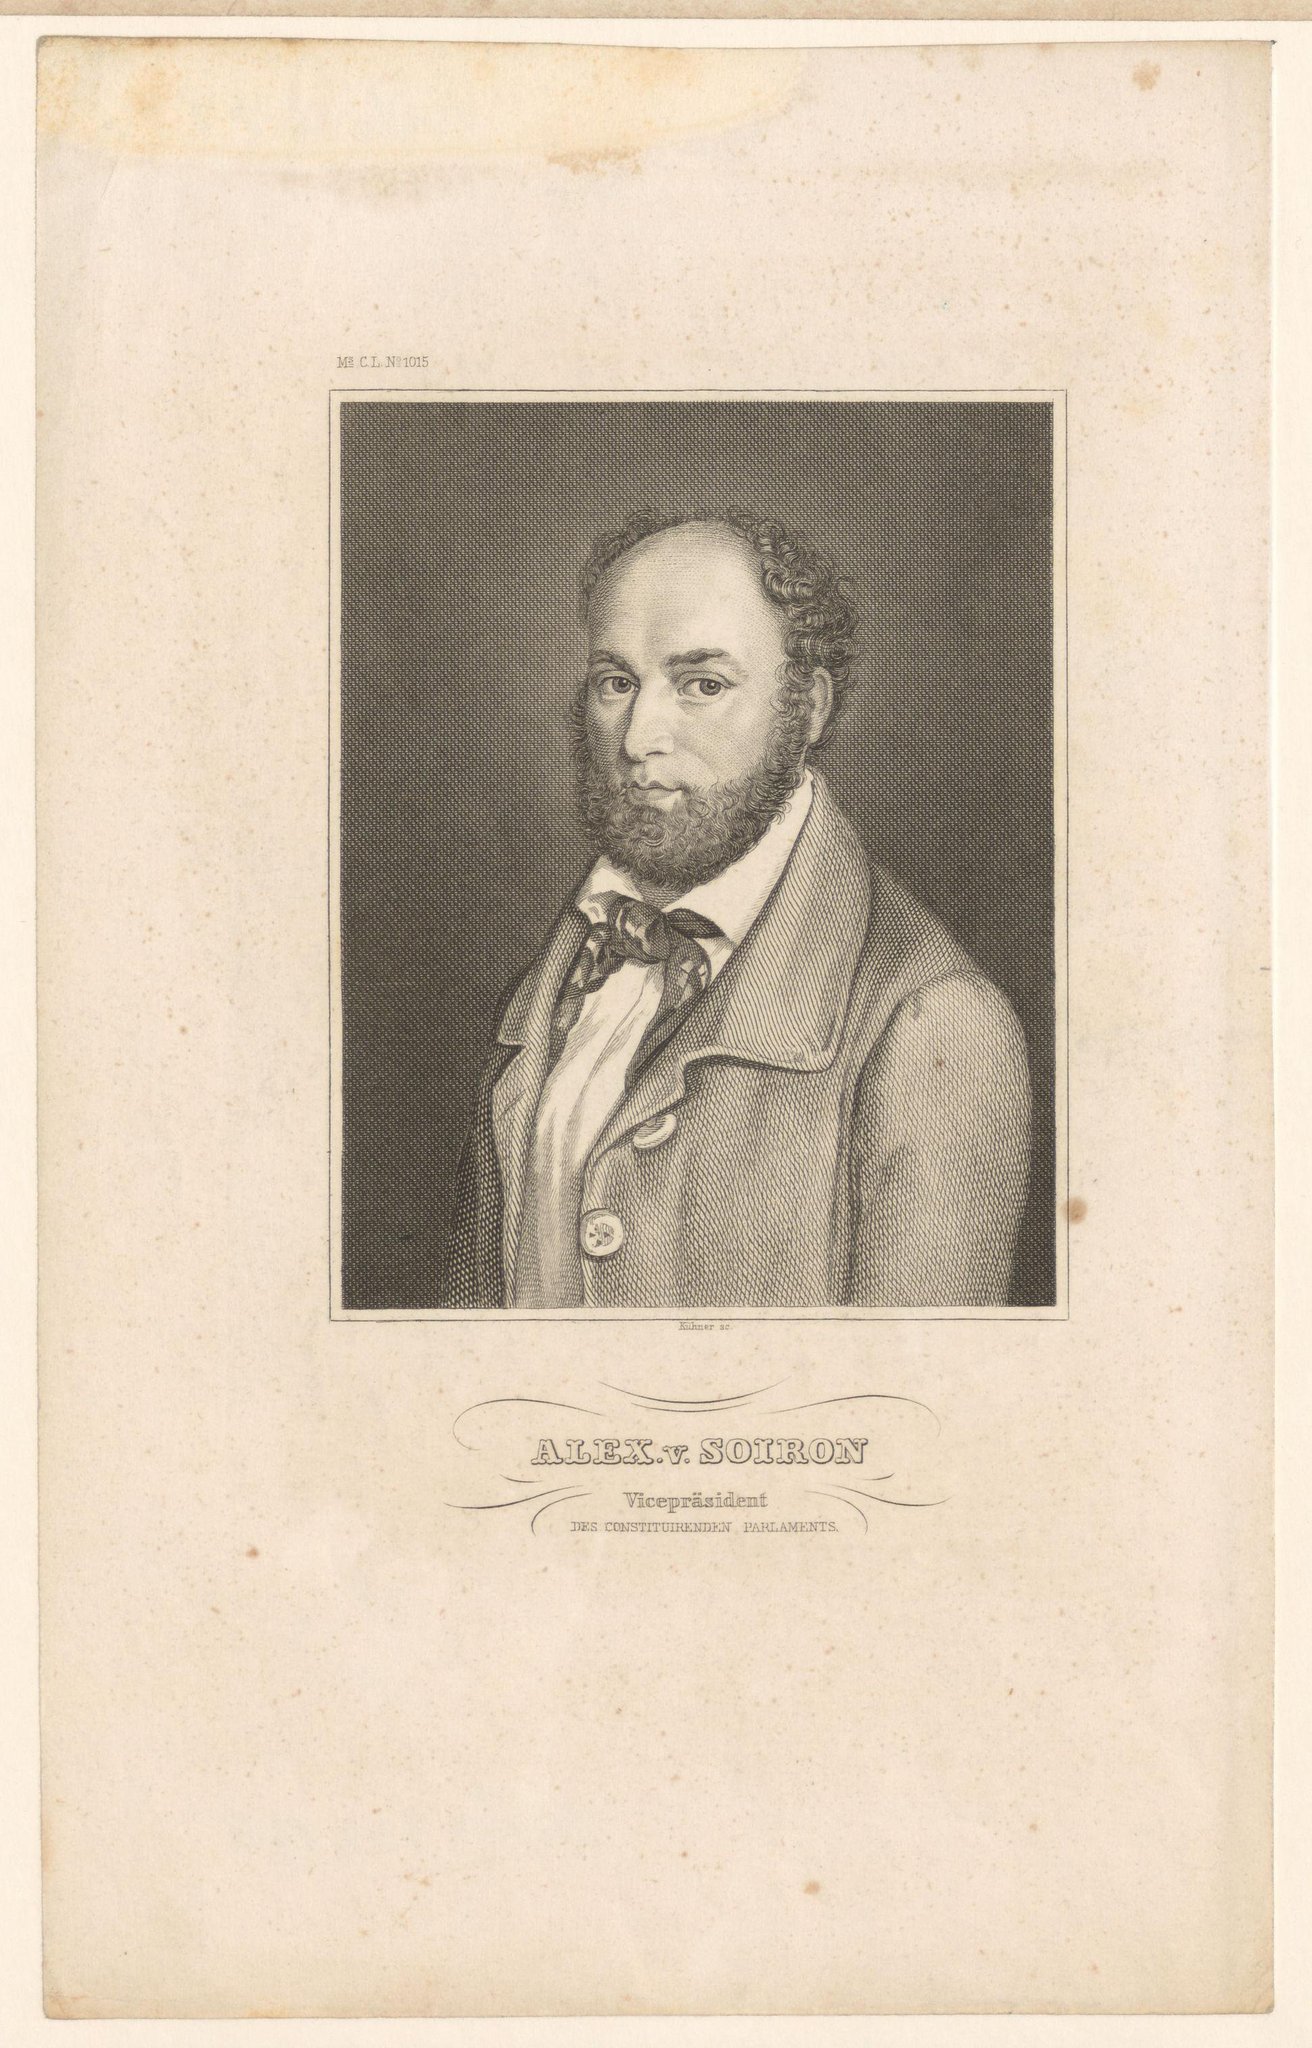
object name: print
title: Portret van Alexander von Soiron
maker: johann christian friedrich kühner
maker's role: artist, painter, print maker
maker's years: 1774-1852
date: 1840-1855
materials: paper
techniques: engraving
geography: hildburghausen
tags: politician, historical persons, politician, e.g. party leader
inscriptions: collector's mark: Lugt 2228, collector's mark: Lugt 2760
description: Prent uit: Meyer, Joseph. Das Grosse Conversations-Lexikon für die gebildeten Stände. Hildburghausen: Bibliographisches Institut, [1840-1855].